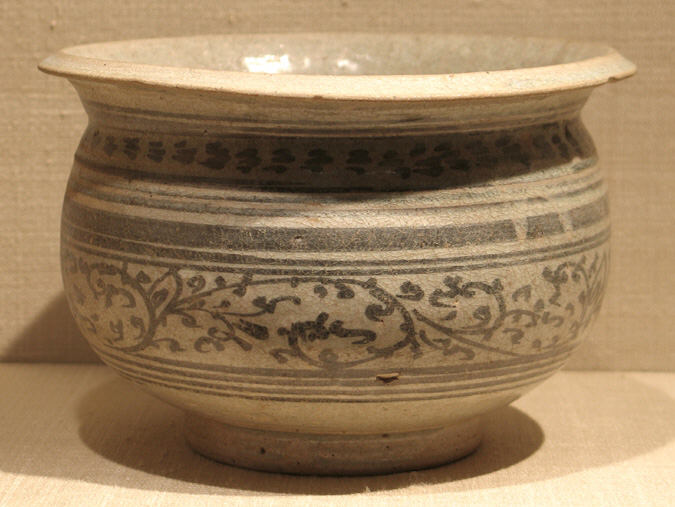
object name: pot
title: Pot with Foliate Design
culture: thai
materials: earthenware, glaze, iron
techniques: underglaze